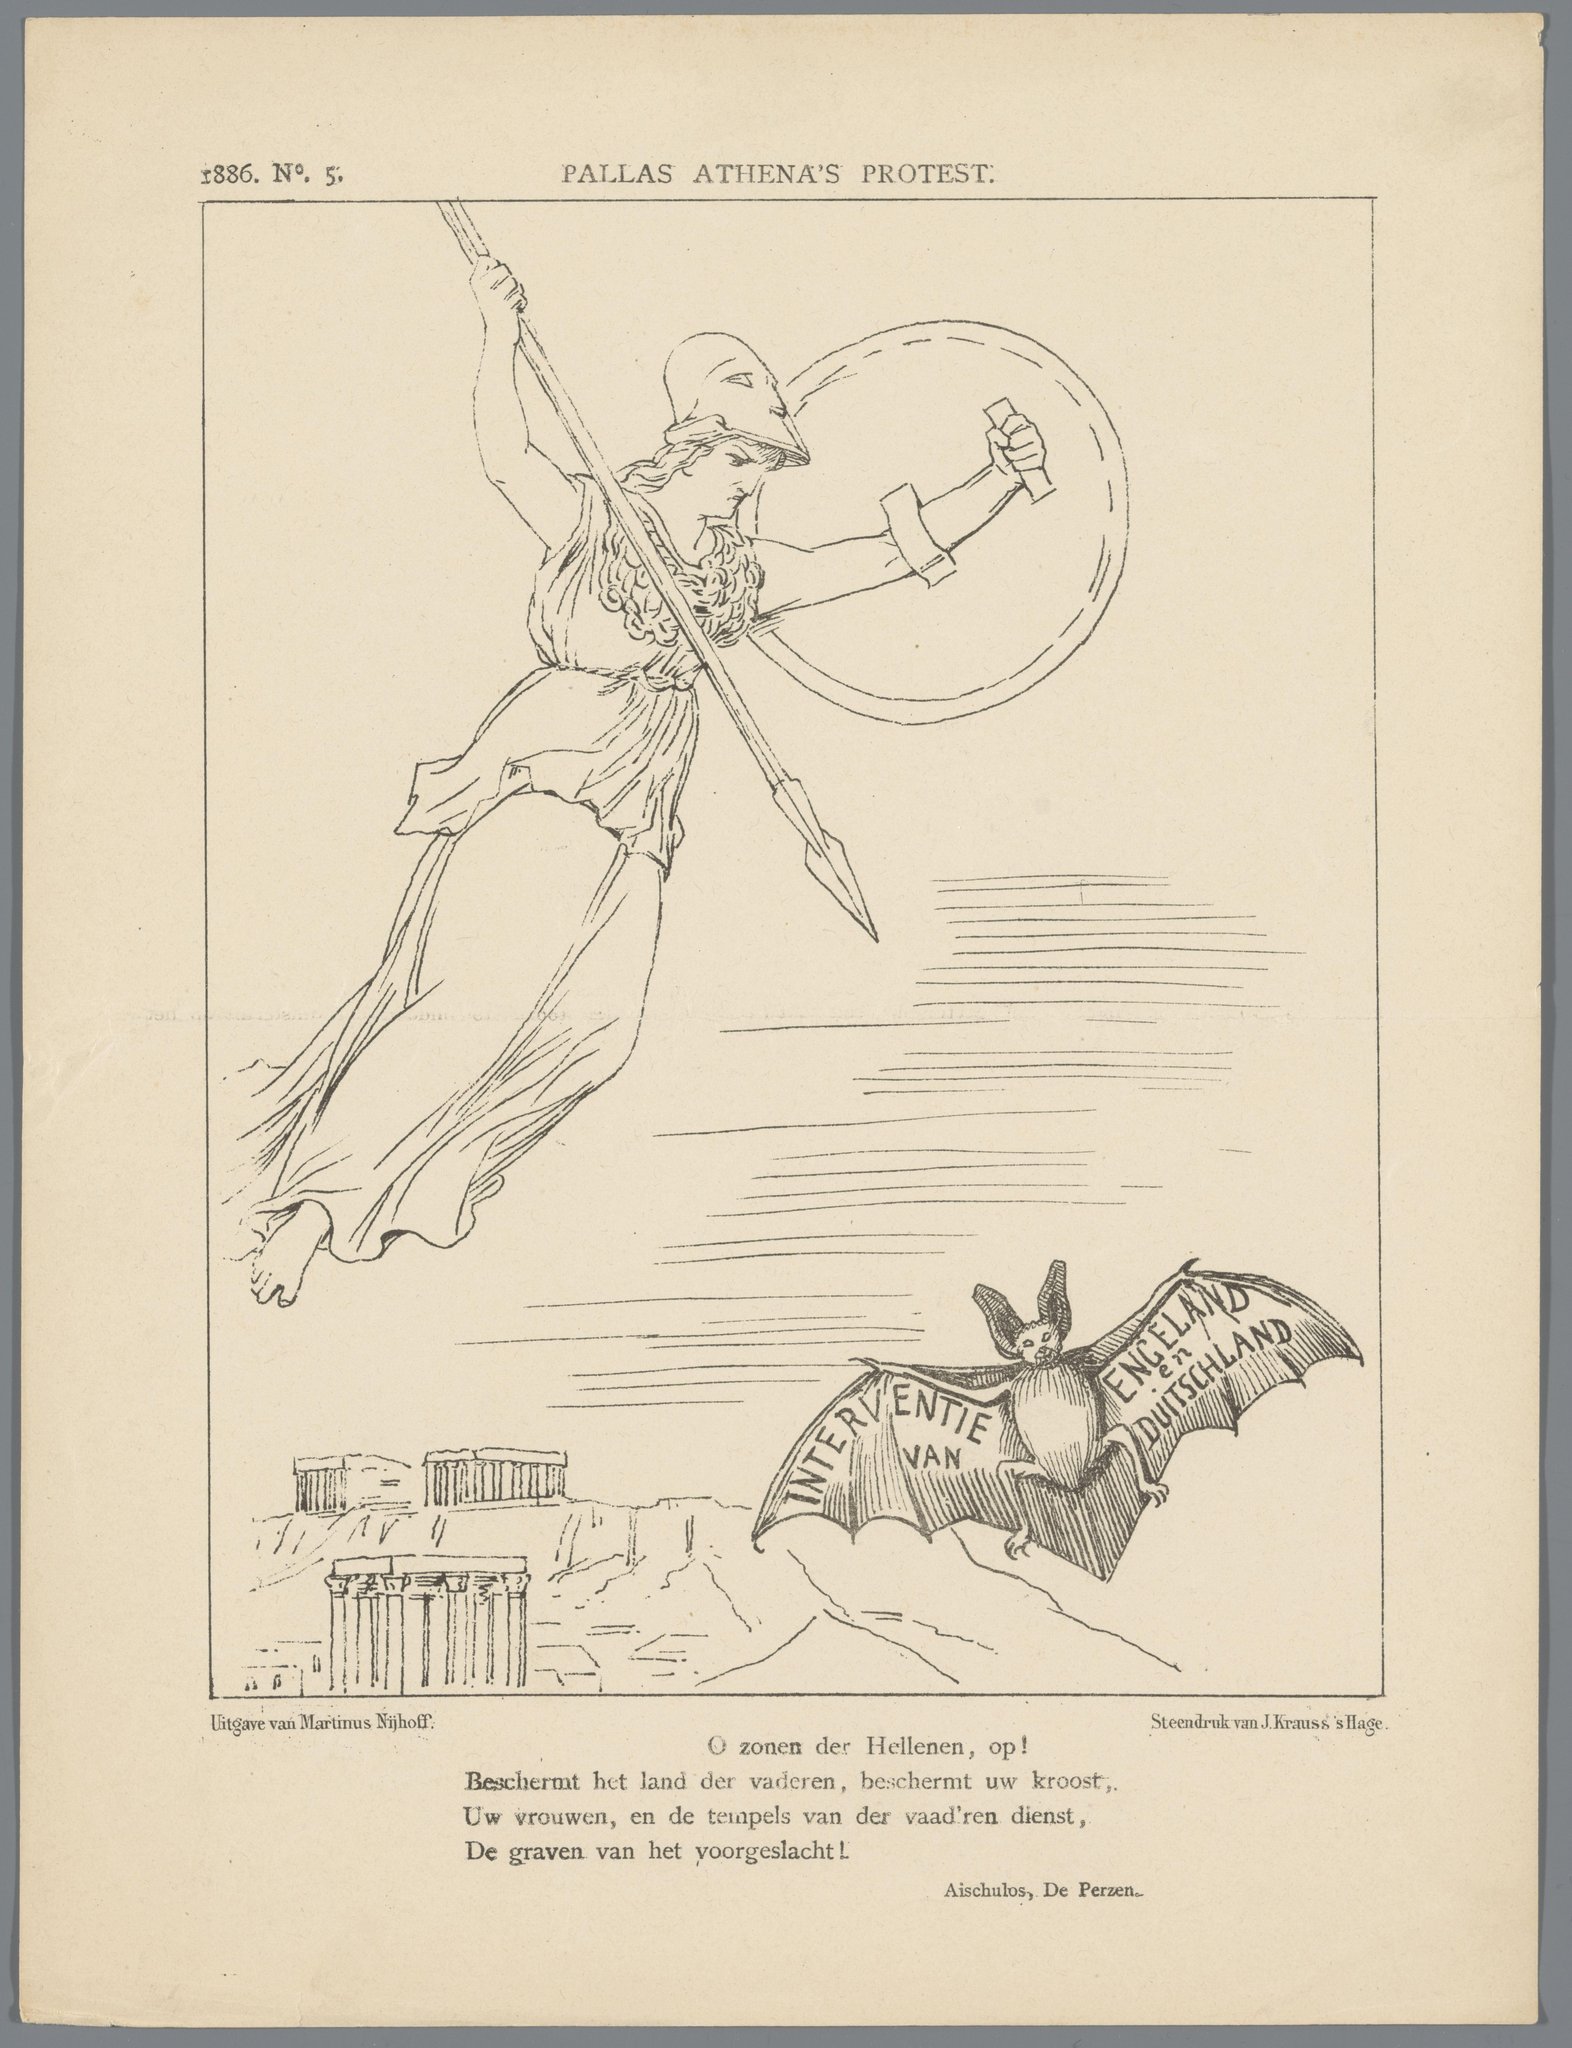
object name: cartoon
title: Pallas Athena's protest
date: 1886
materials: paper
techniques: lithograph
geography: the hague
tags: griekenland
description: Politieke spotprent over de interventie van Engeland en Duitsland (in Griekenland?). Plaat verschenen bij het weekblad De Nederlandsche Spectator, nr. 5, 1886.